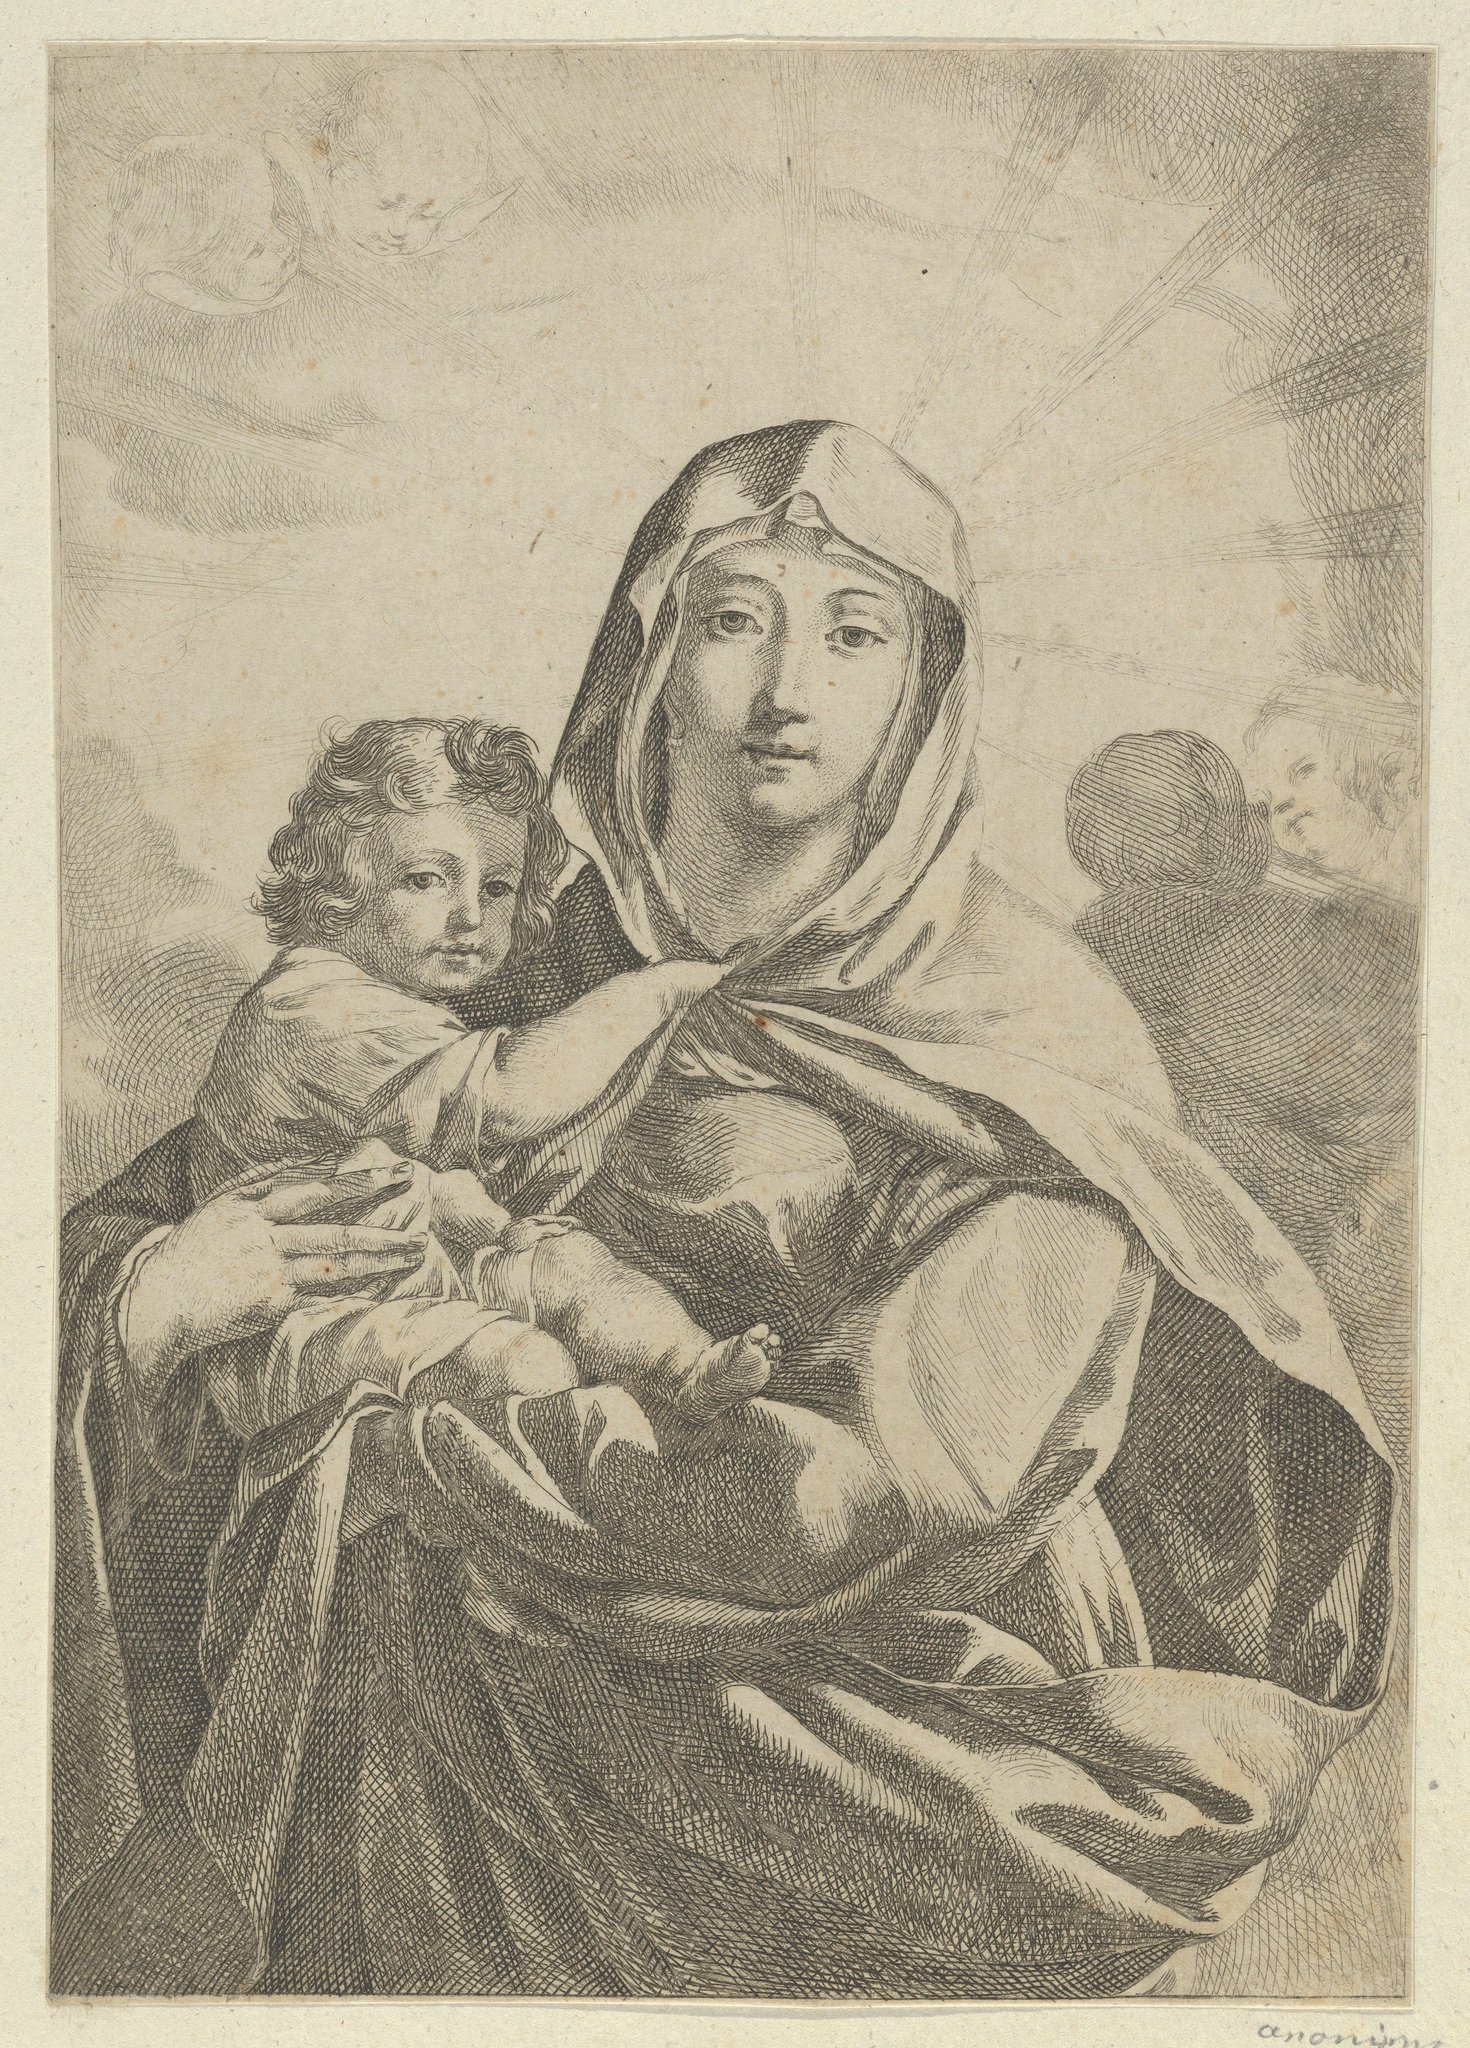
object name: print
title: The Virgin standing facing front and holding the infant Christ, angels behind them in the clouds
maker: Anonymous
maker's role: artist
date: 1700-1800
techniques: etching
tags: madonna and child,virgin mary,jesus